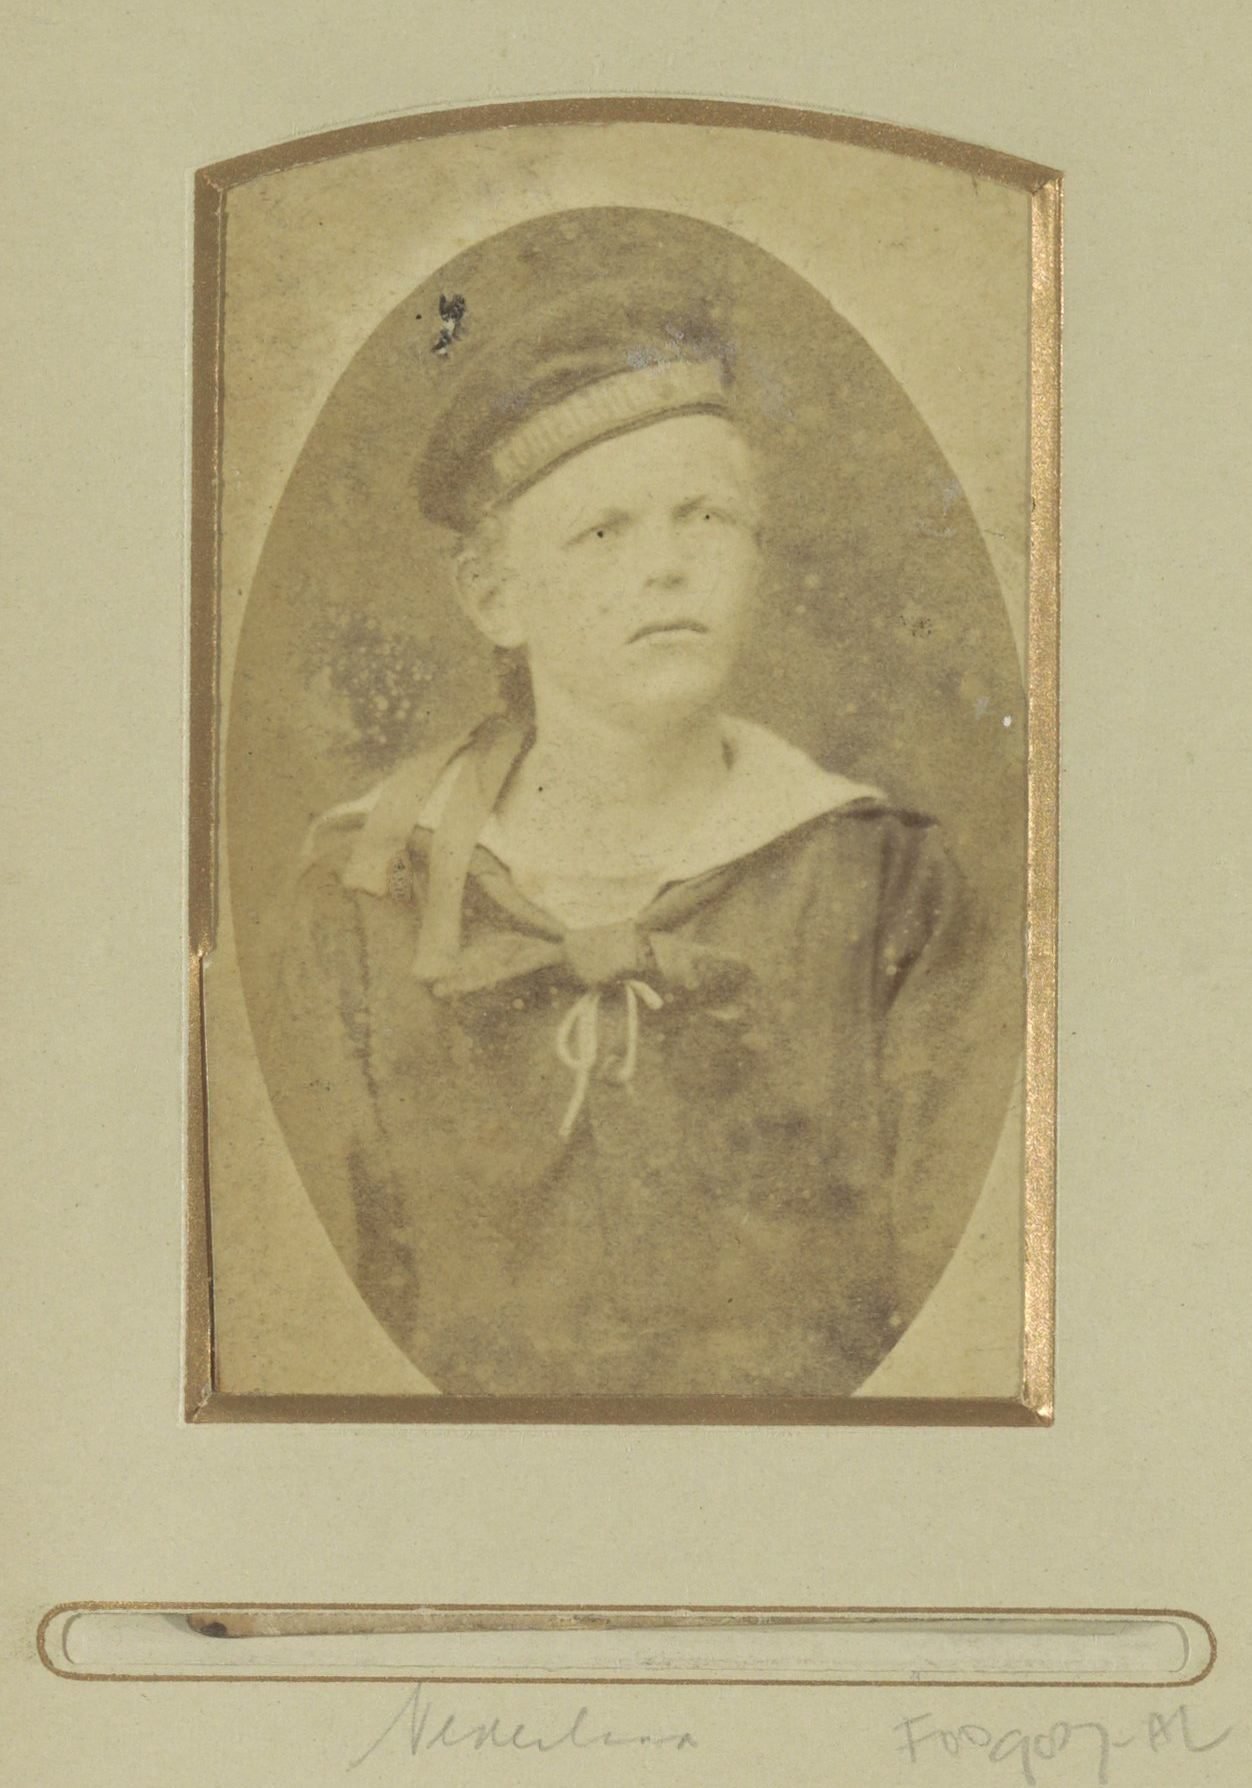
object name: album leaf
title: Portret van een (vermoedelijk) Nederlandse matroos van de Koninklijke Marine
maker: abraham swaab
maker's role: fotograaf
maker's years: 1834-1916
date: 1870-1900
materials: cardboard, paper, photographic support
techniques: albumen print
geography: den helder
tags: navy, warfare; military affairs, (military) uniforms, division of armed forces, den helder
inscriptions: address: ‘Kanaalweg, hoek Langesteeg Helder’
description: Onderdeel van Album met cartes-de-visite en kabinetfoto's van militairen in uniform.